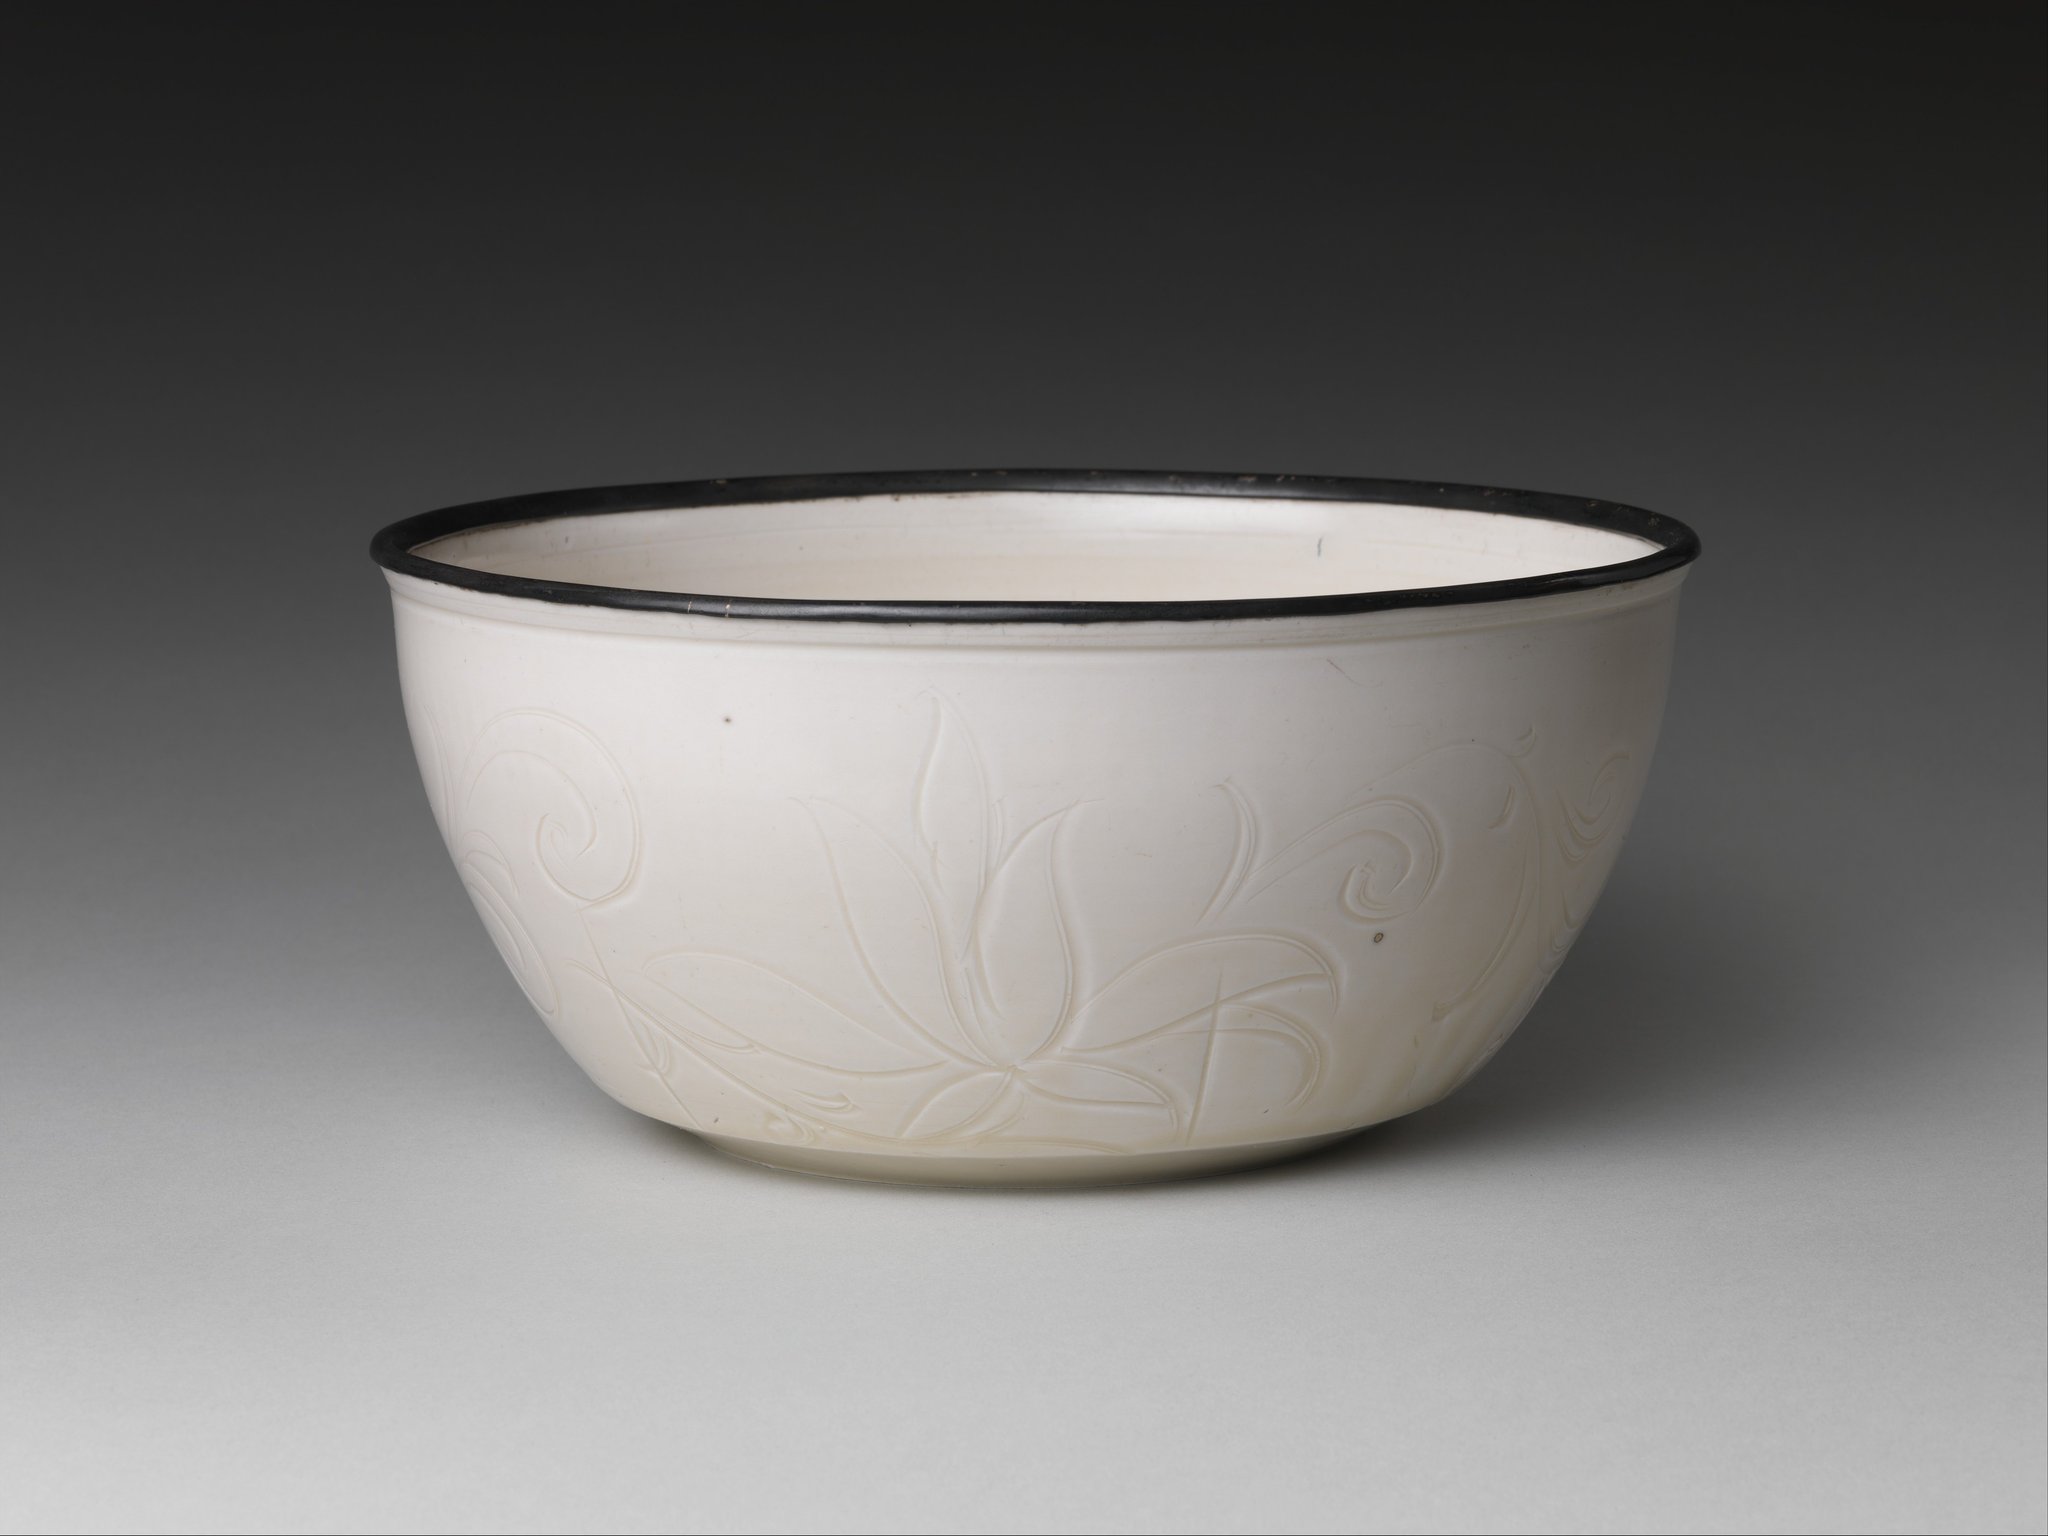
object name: basin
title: Basin with Lotus Decoration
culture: chinese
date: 1001-1200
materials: glaze, ivory, porcelain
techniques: carving, incising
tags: lotuses